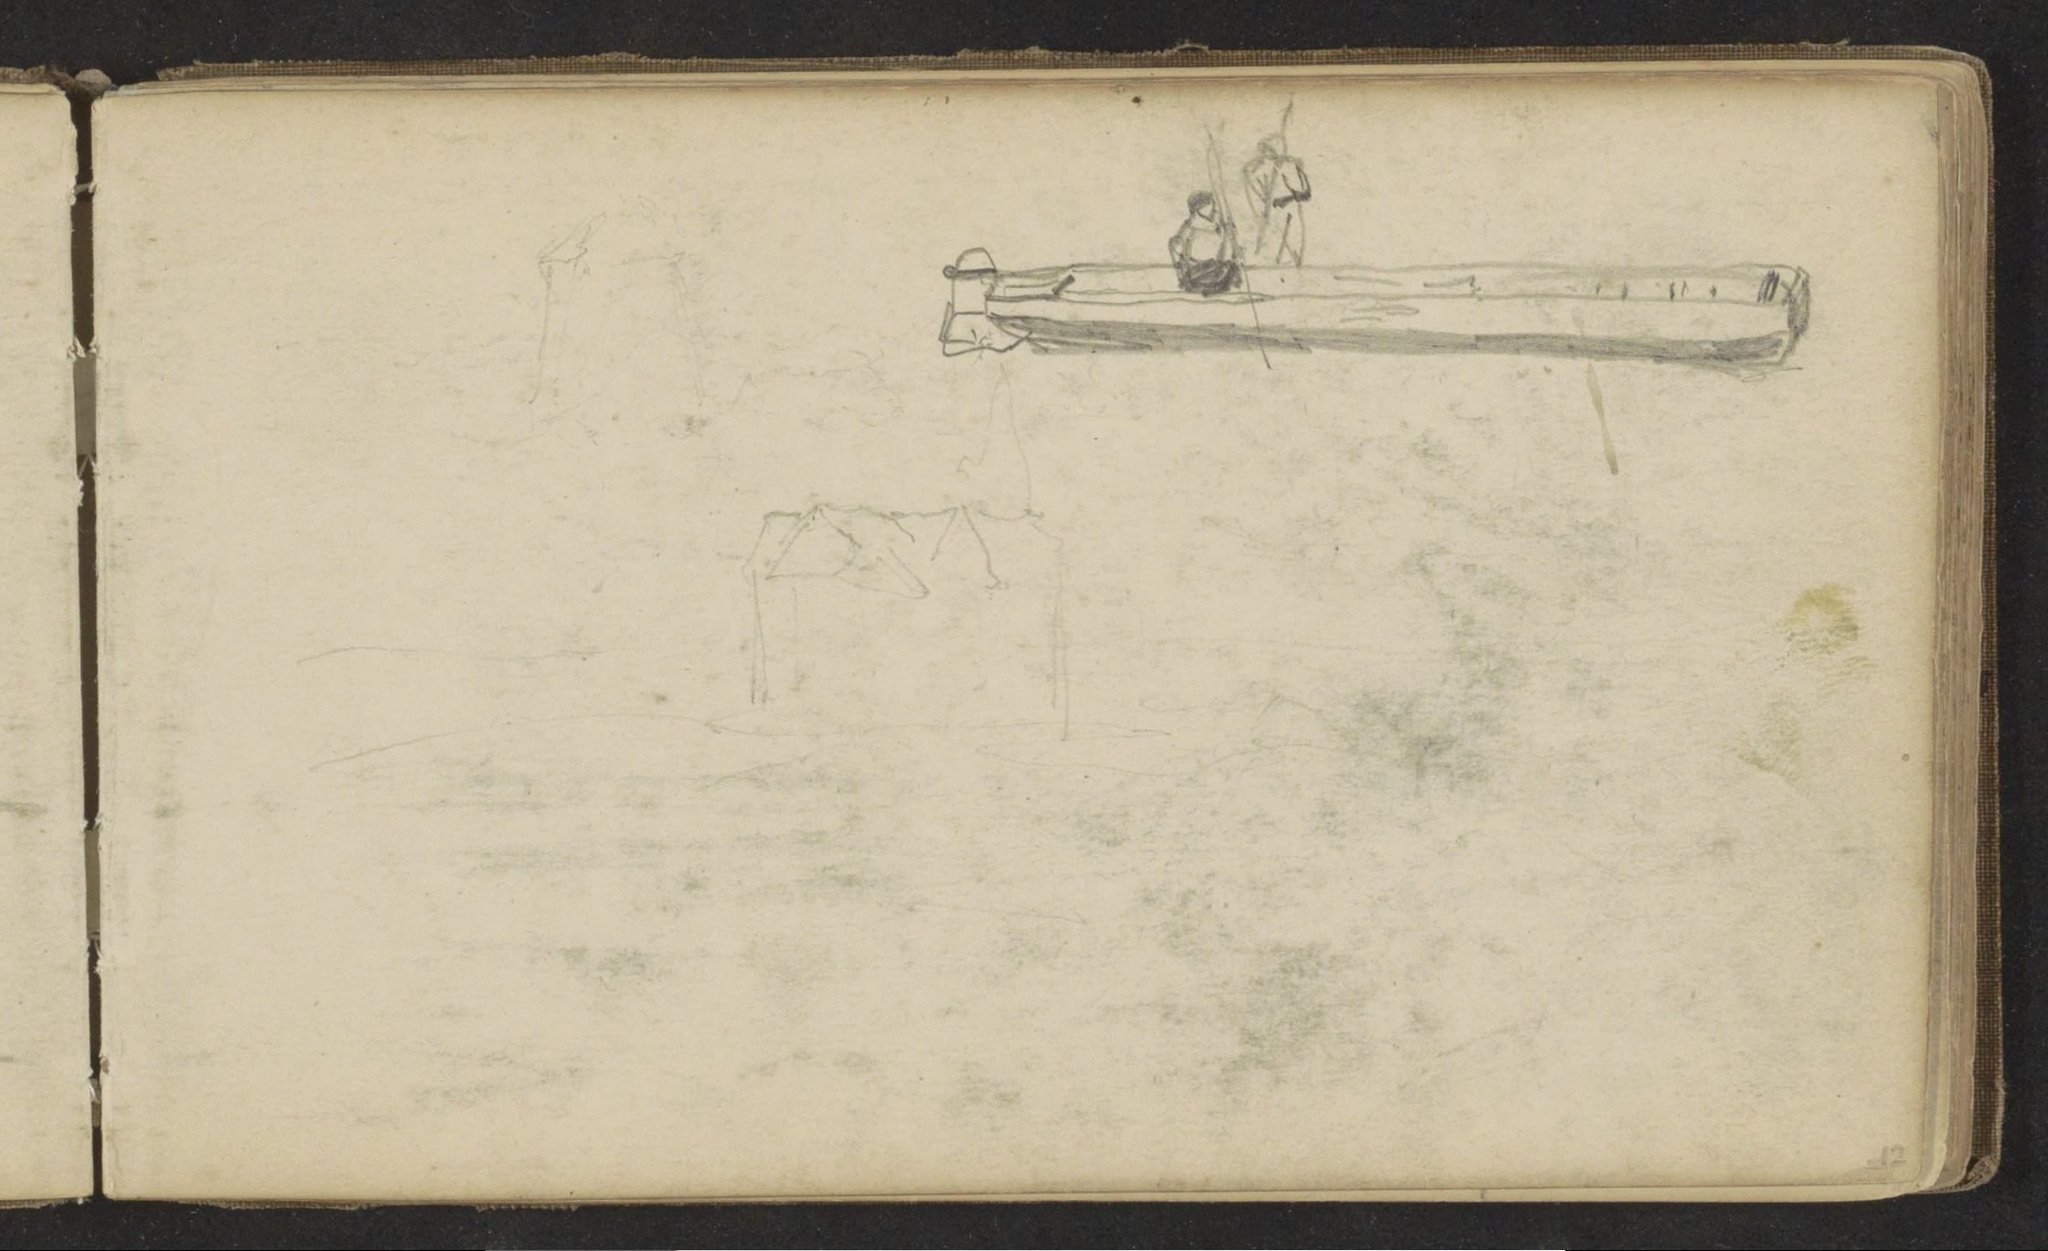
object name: sketchbook leaf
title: Twee figuren op een schuit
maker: johan hendrik weissenbruch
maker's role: draughtsman, painter, print maker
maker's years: 1824-1903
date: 1834-1903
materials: paper, pencil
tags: boat propelled by man or animal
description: Tevens studies van huizen. Blad 12 recto uit een schetsboek met 43 bladen.